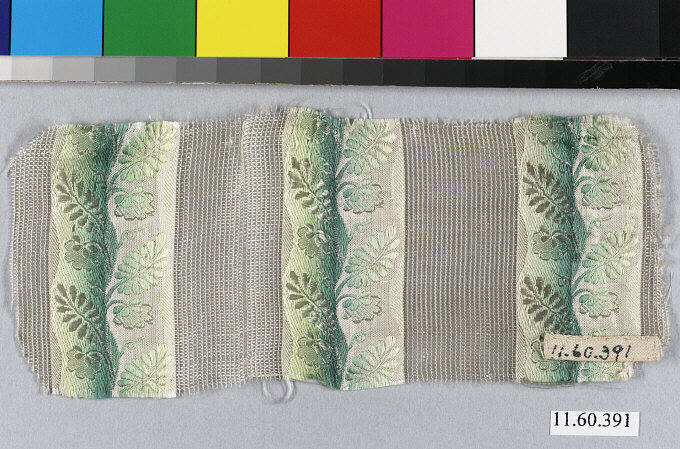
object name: fragment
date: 1801-1900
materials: silk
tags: leaves